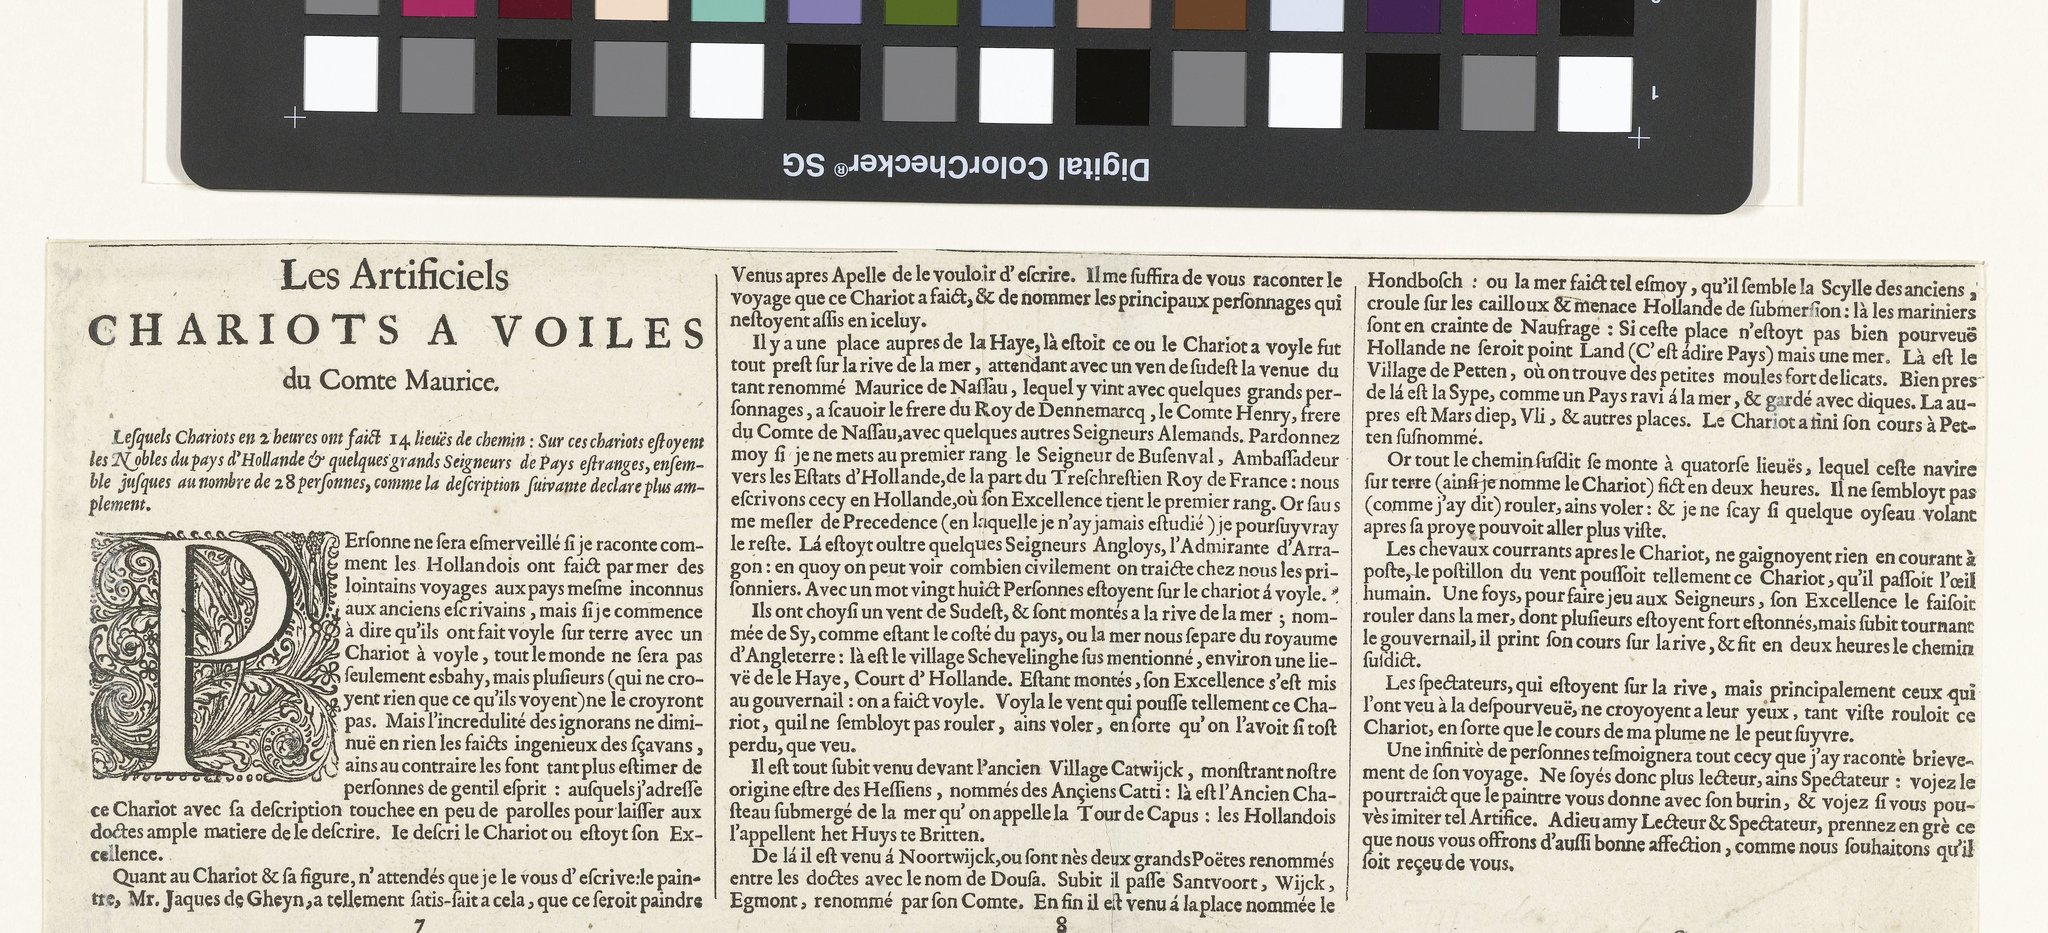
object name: print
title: Toelichting van de werking van de zeilwagen van Simon Stevin, 1602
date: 1603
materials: paper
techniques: letterpress printing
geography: amsterdam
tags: the hague, maurice (prince of orange), bruges, simon stevin, sailing-car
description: Toelichting van de werking van de zeilwagen van Simon Stevin, 1602. Drie kolommen tekst in het Frans. Onderdelen genummerd 7, 8 en 9. Met versierde initiaal P. Dit blad behoort losgesneden en aan de zijkanten en onderzijde van de grote prent van de zeilwagen in drie platen gemonteerd te worden.